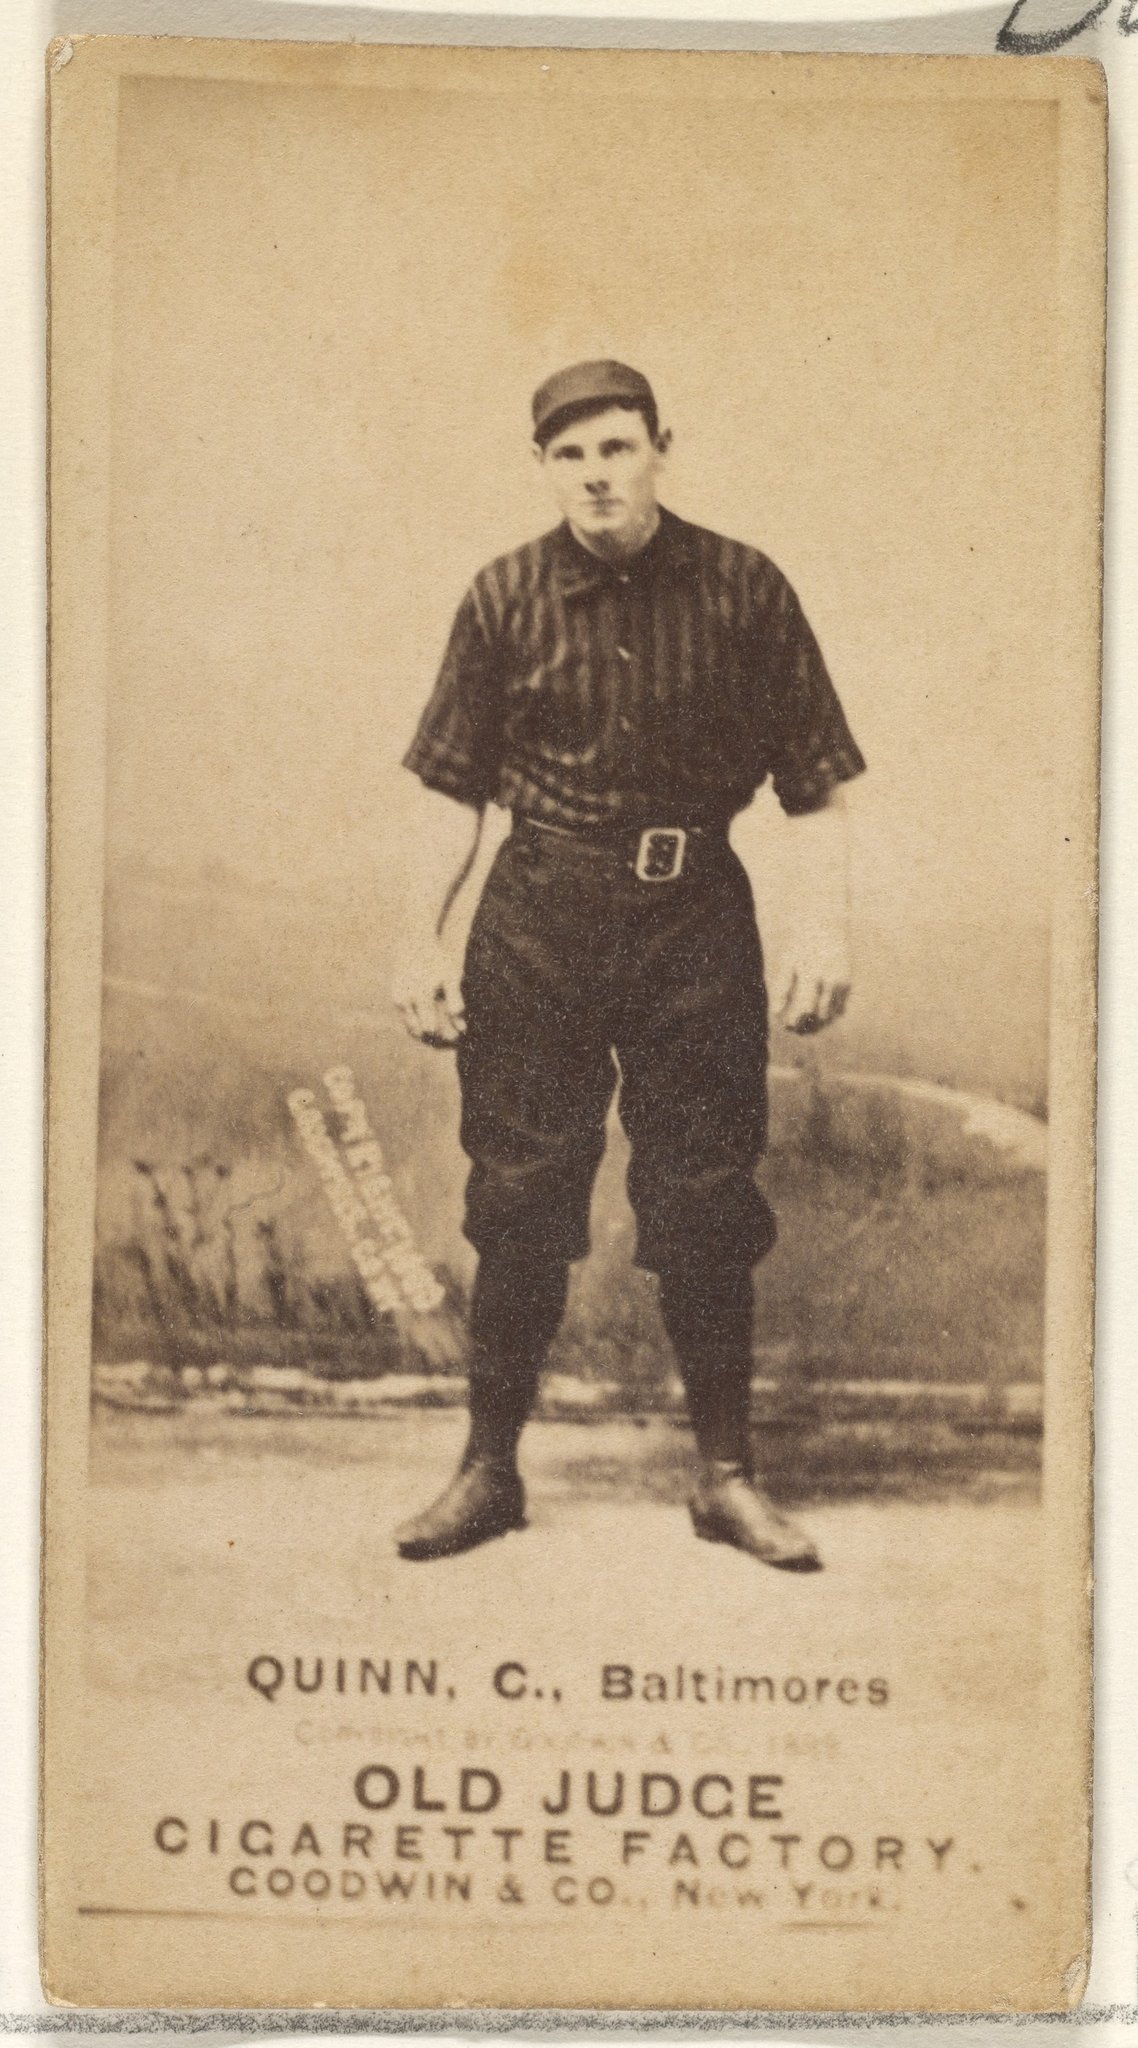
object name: baseball card, photograph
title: Quinn, Catcher, Baltimore Orioles, from the Old Judge series (N172) for Old Judge Cigarettes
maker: goodwin & company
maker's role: publisher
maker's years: 1850-1950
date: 1887-1890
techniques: albumen silver print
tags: men,portraits,baseball,athletes